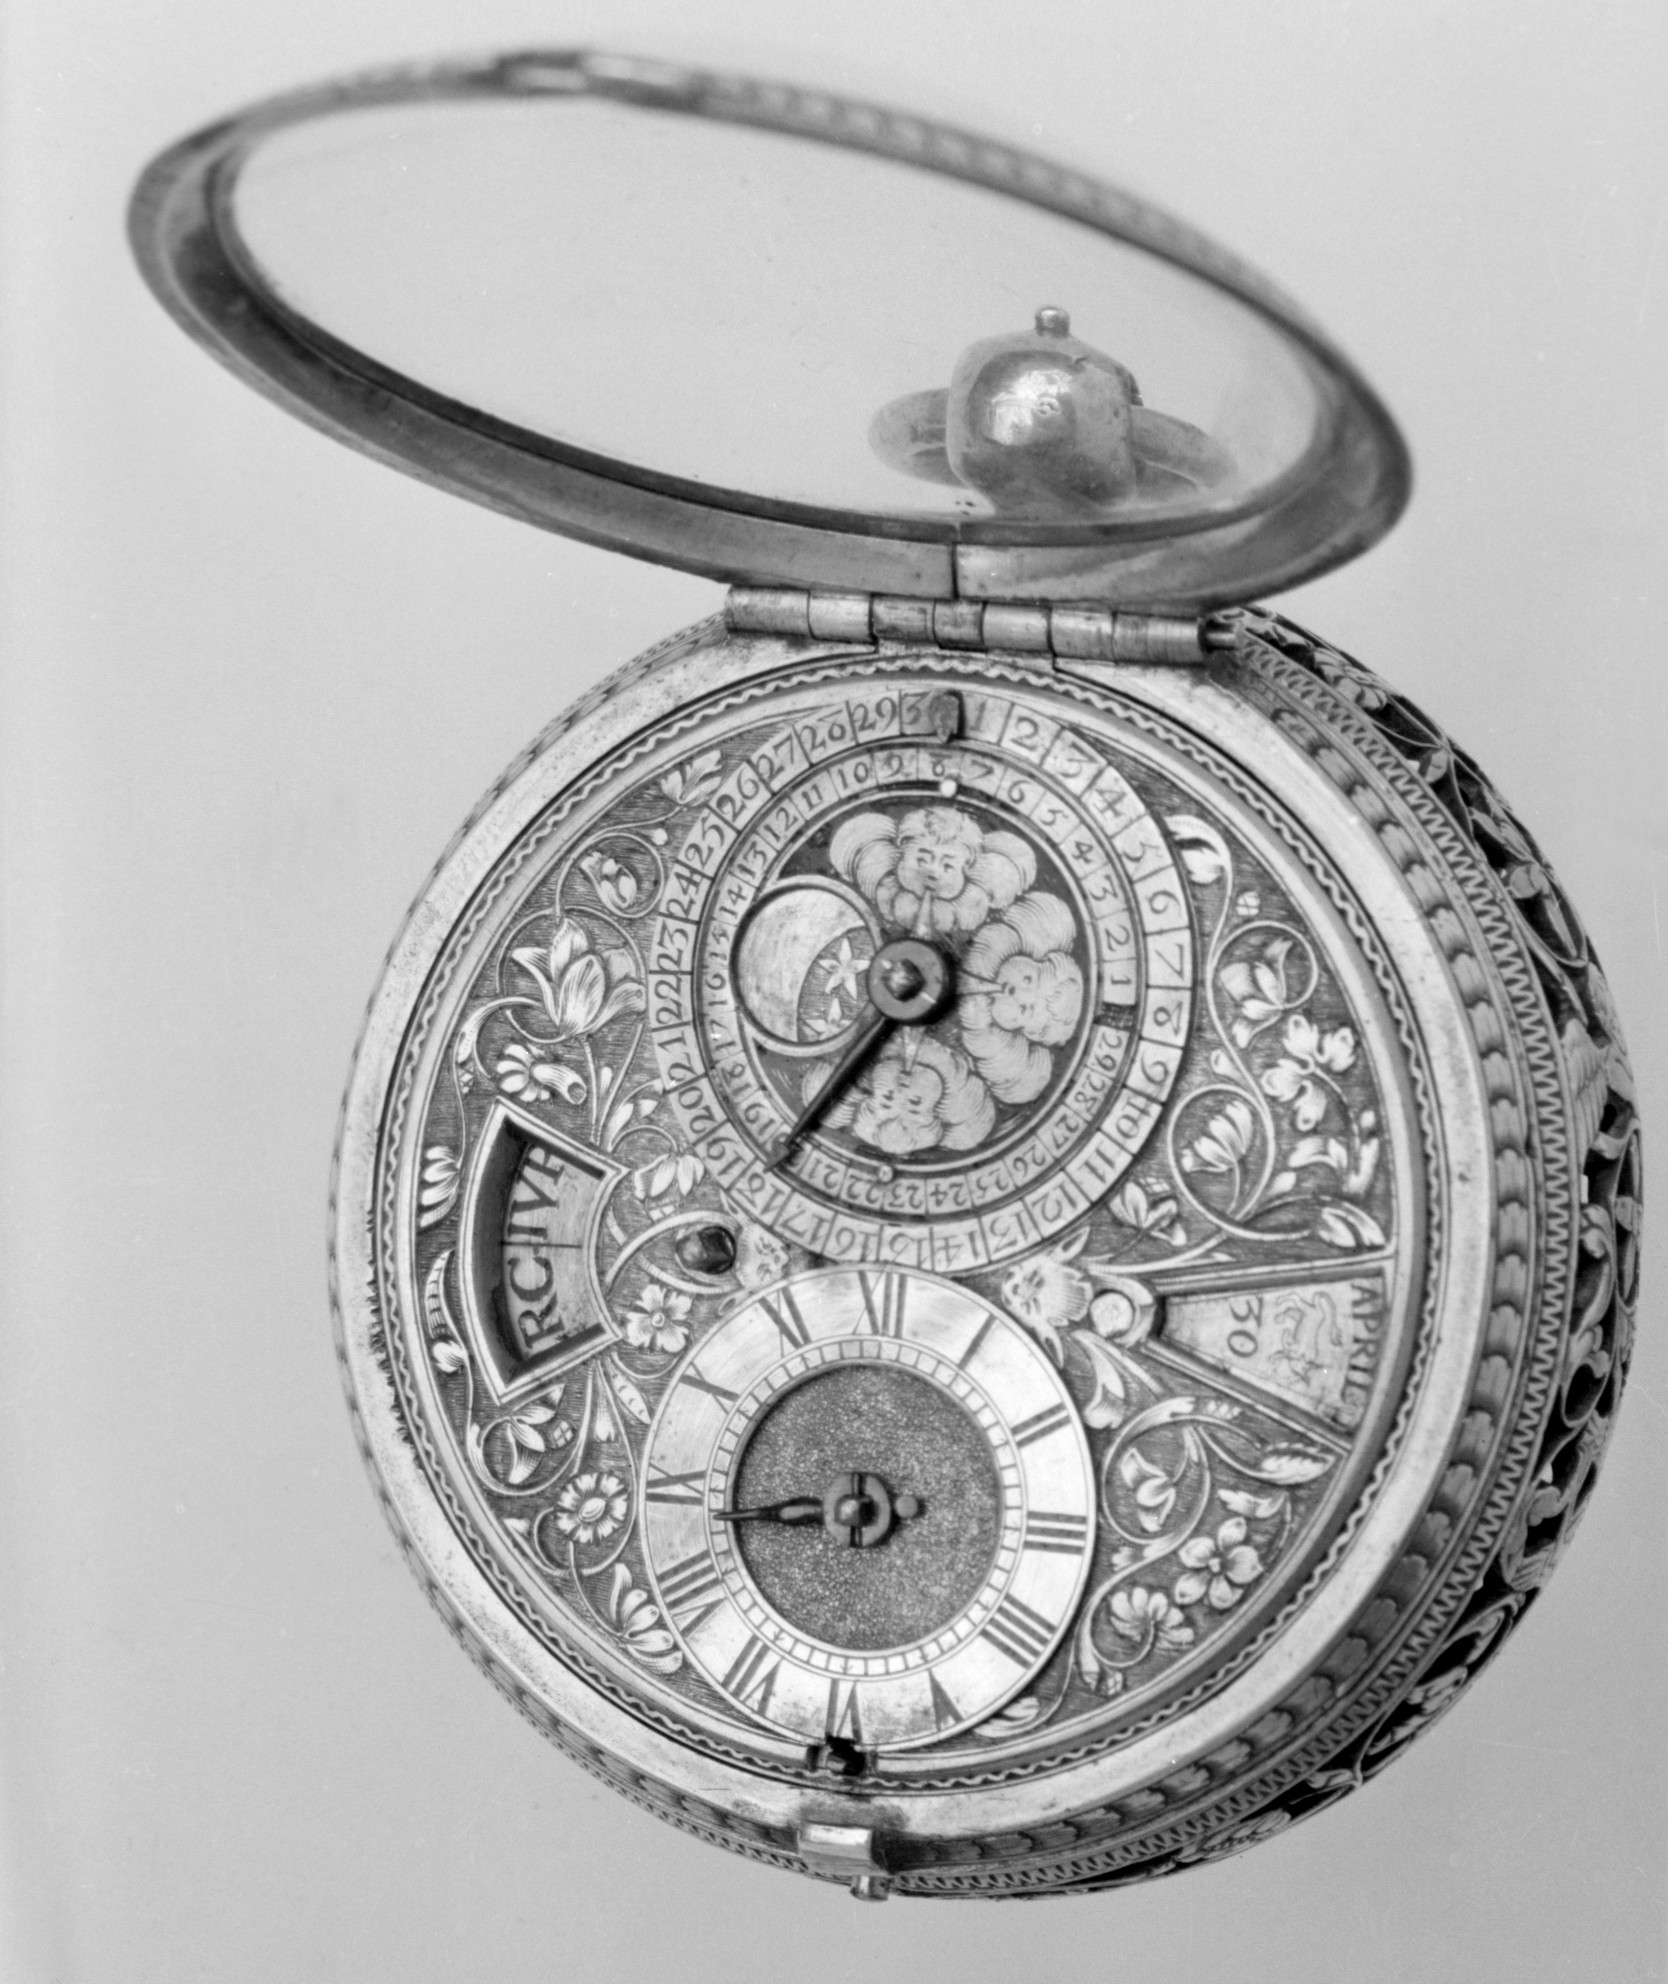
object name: pair case watch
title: Astronomical pair-case watch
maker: abraham pattey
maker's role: maker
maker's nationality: swiss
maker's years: 1627-1702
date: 1680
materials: leather, silver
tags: faces,flowers